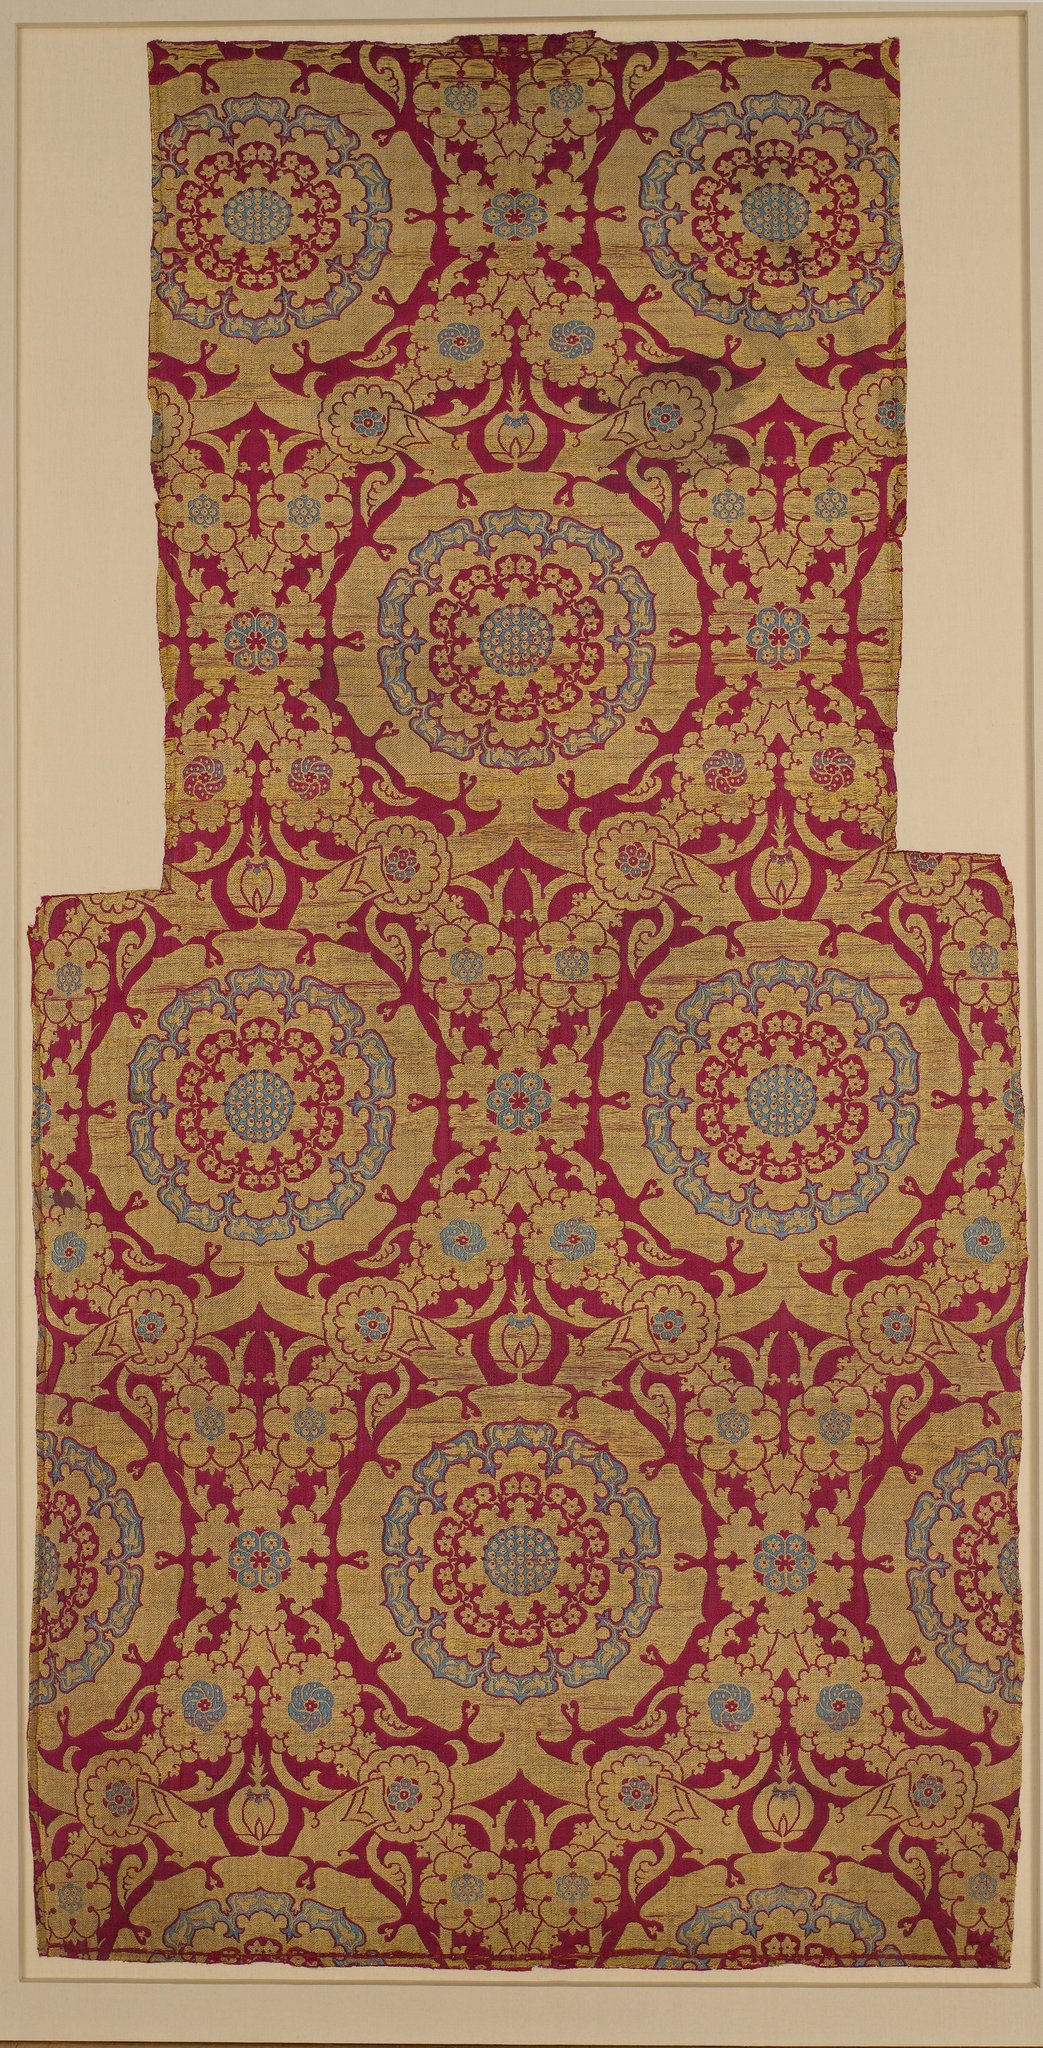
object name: textile fragment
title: Silk Fragment with Circular Rosace-like Floriate Medallions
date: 1501-1550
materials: metal thread, silk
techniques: lampas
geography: turkey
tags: flowers